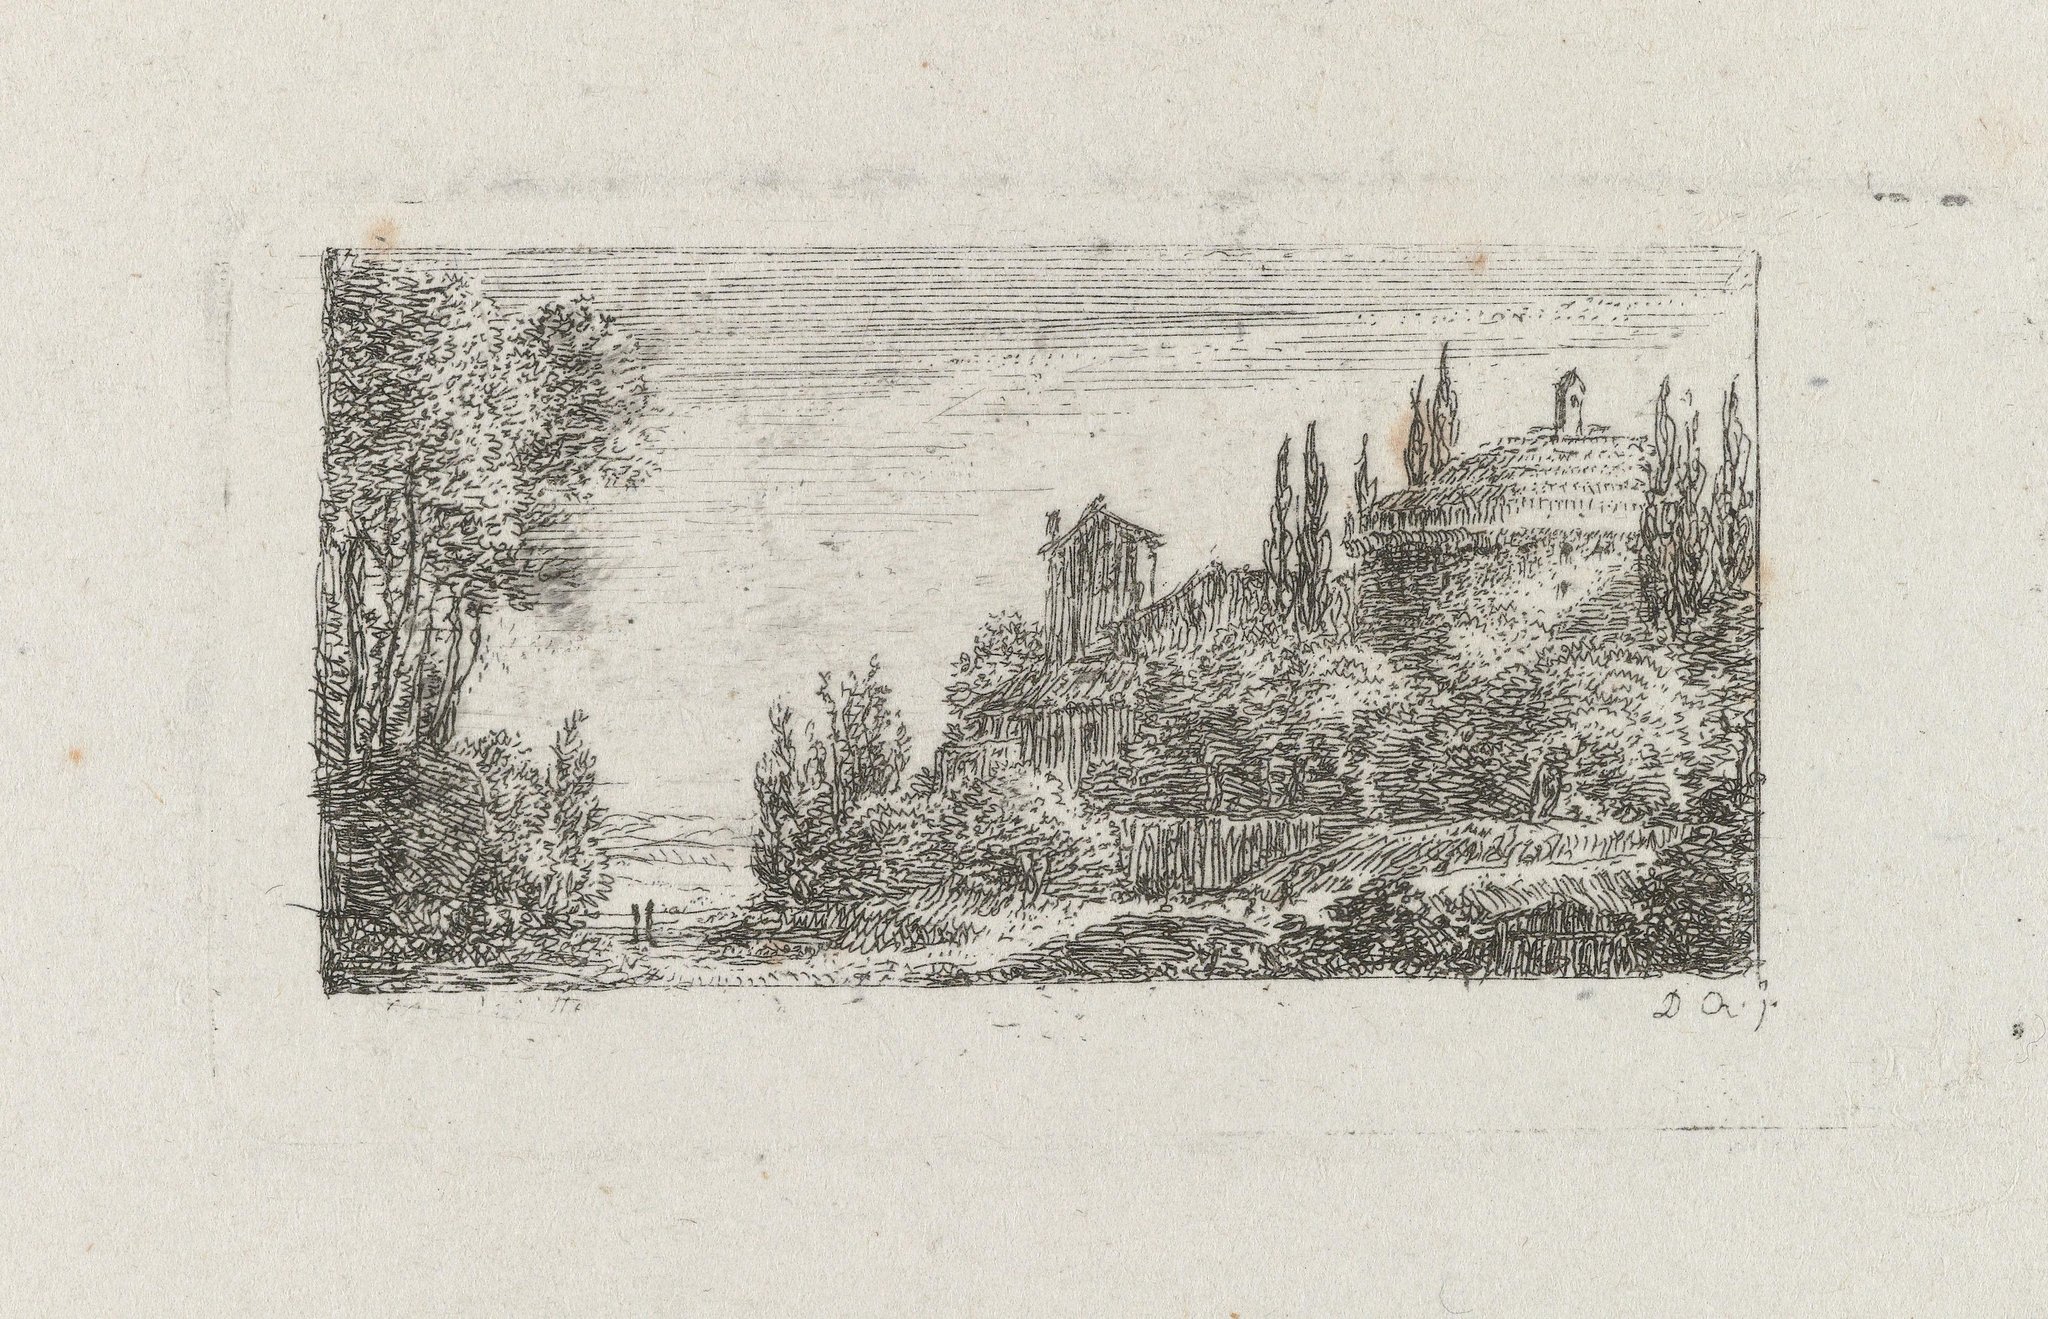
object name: print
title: Vier und Zwanzig Landschaftliche Gegenstände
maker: johann velten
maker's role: print maker, publisher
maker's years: 1784-1864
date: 1804-1810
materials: paper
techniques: etching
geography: karlsruhe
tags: architecture (+ gothic art), landscapes in the temperate zone (+ landscape with figures, staffage)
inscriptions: collector's mark: Lugt 2760, collector's mark: Lugt 2228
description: Deze prent maakt deel uit van een serie van 24 prenten.